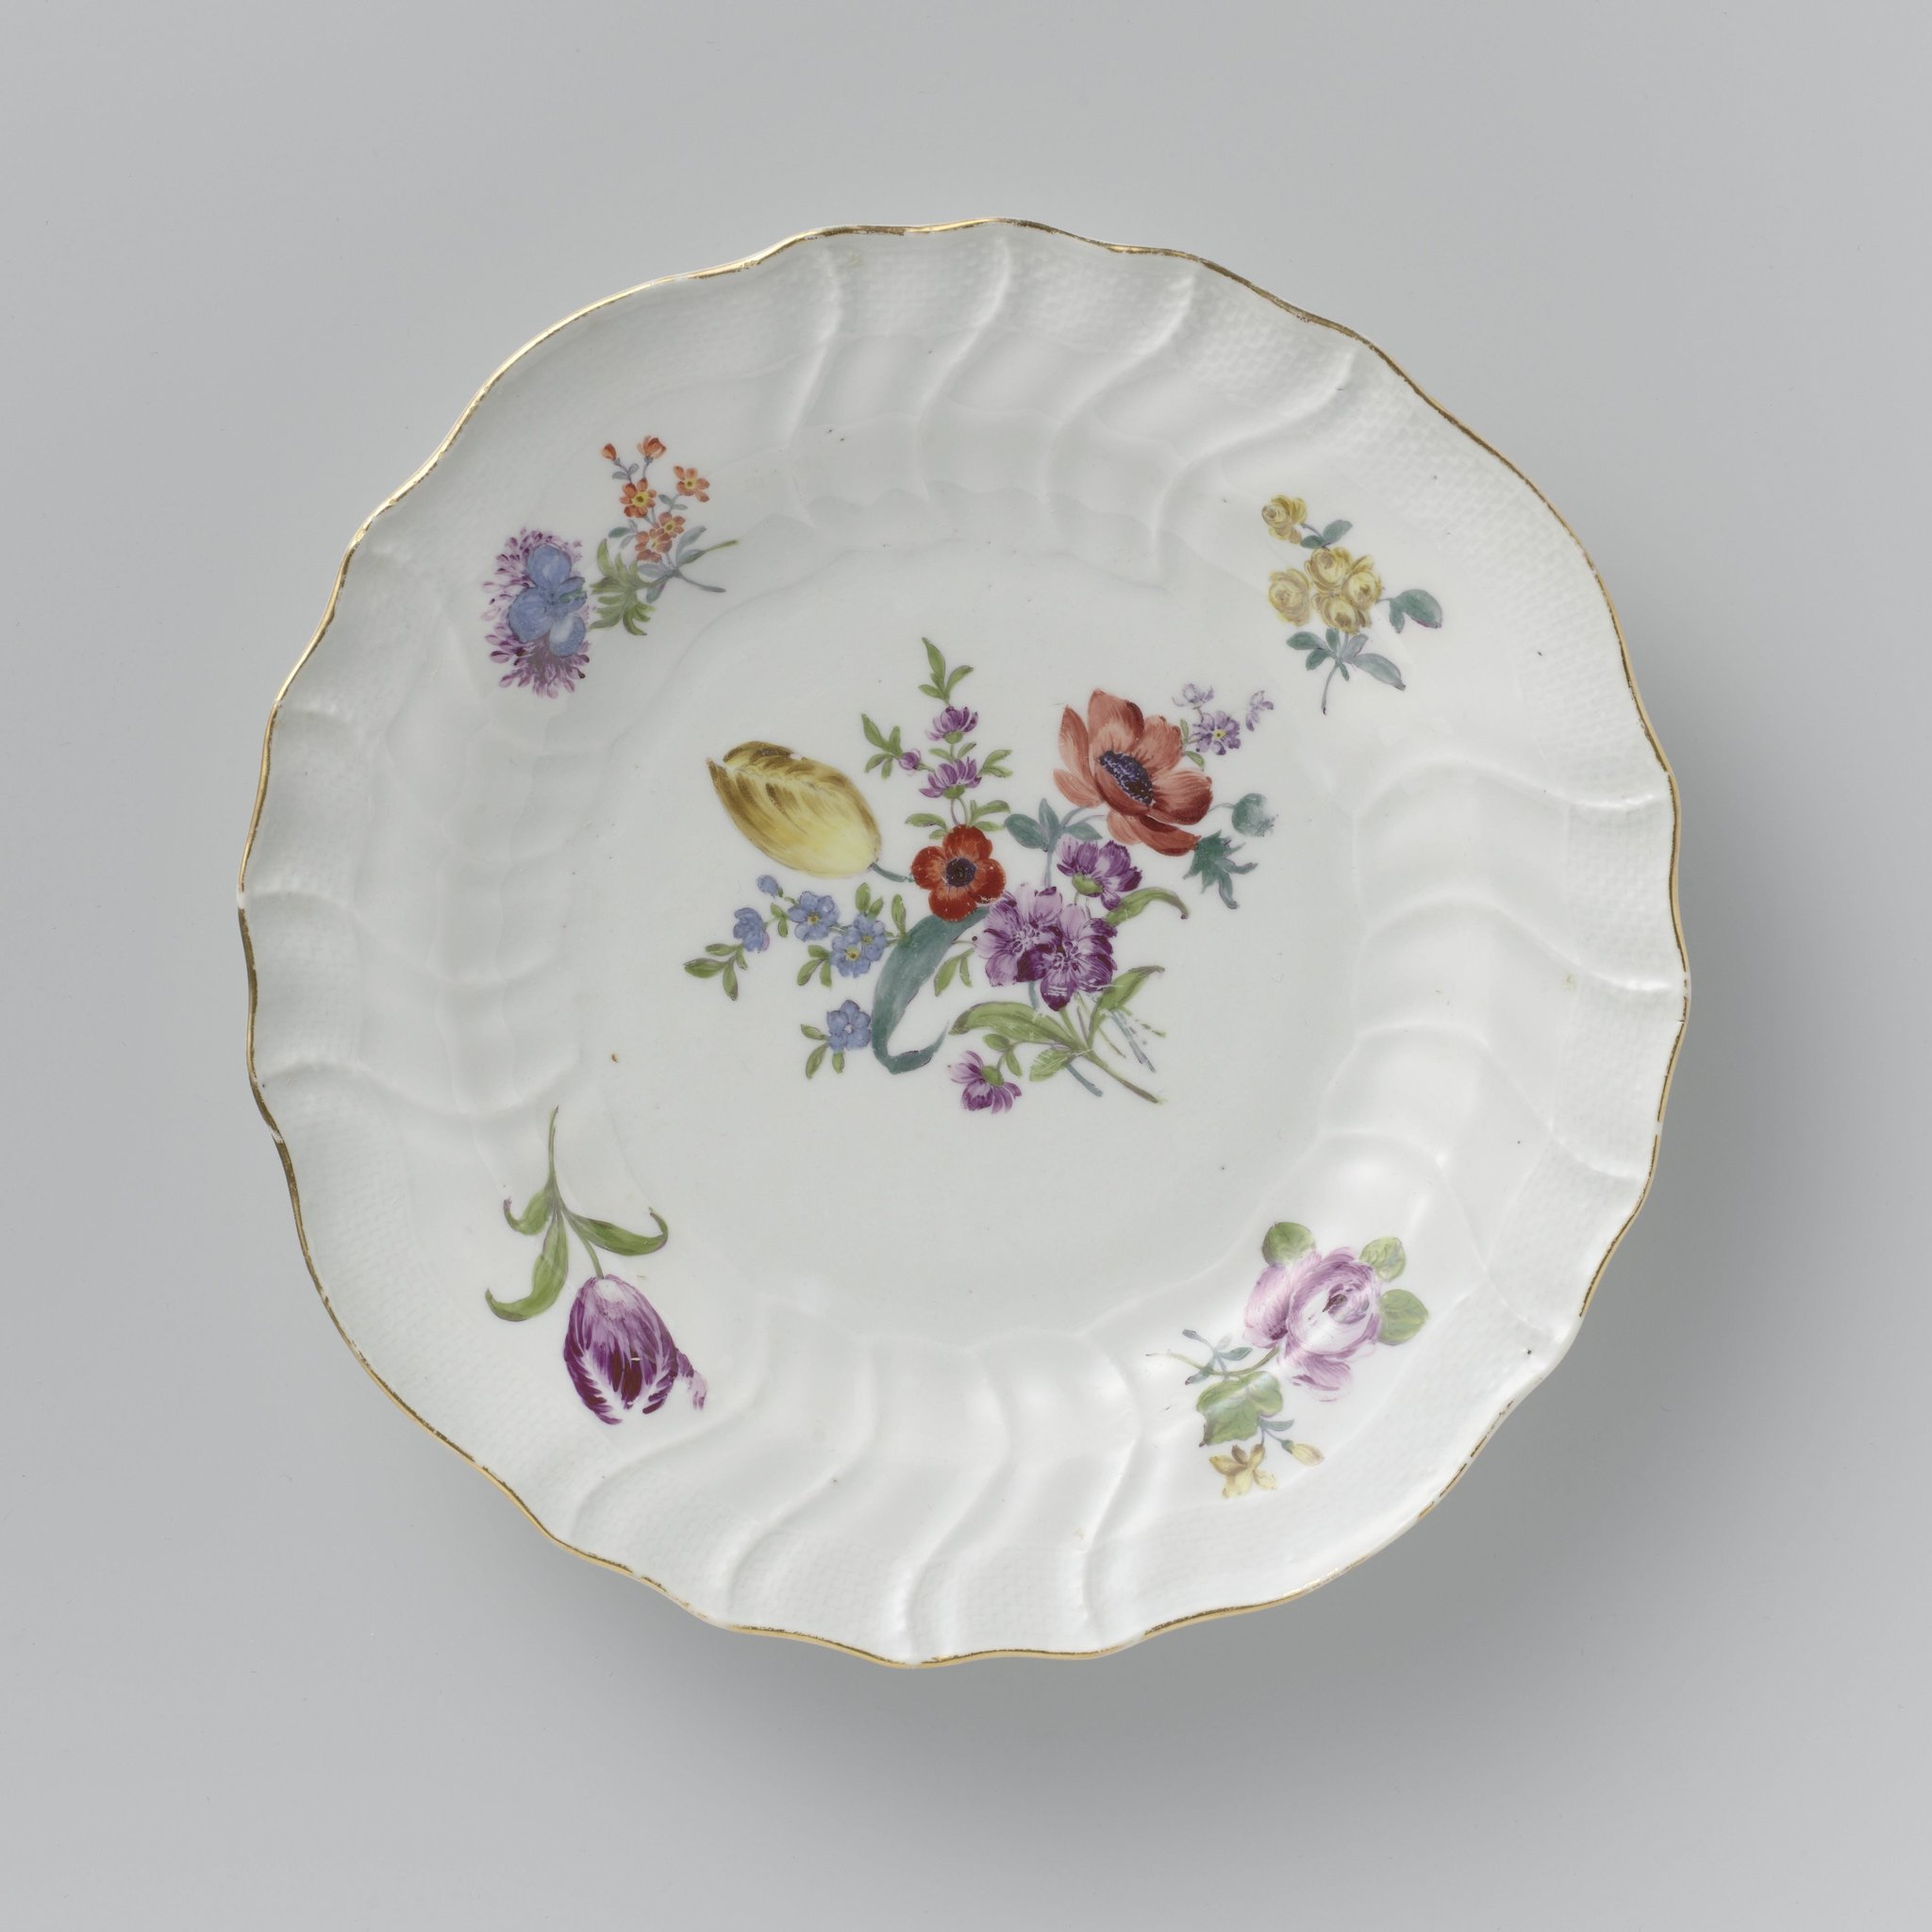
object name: plate dish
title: Bord, veelkleurig beschilderd met Deutsche Blumen, insekten en vruchten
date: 1750-1760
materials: porcelain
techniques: painted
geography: meissen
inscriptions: factory mark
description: Rond bord van beschilderd porselein. De rand is versierd met het Neuozier-patroon in reliëf. De beschildering bestaat uit Deutsche Blumen, insekten en vruchten. Het bord is gemerkt en hoort bij een servies (BK-17474-1 t/m BK-17474-253).